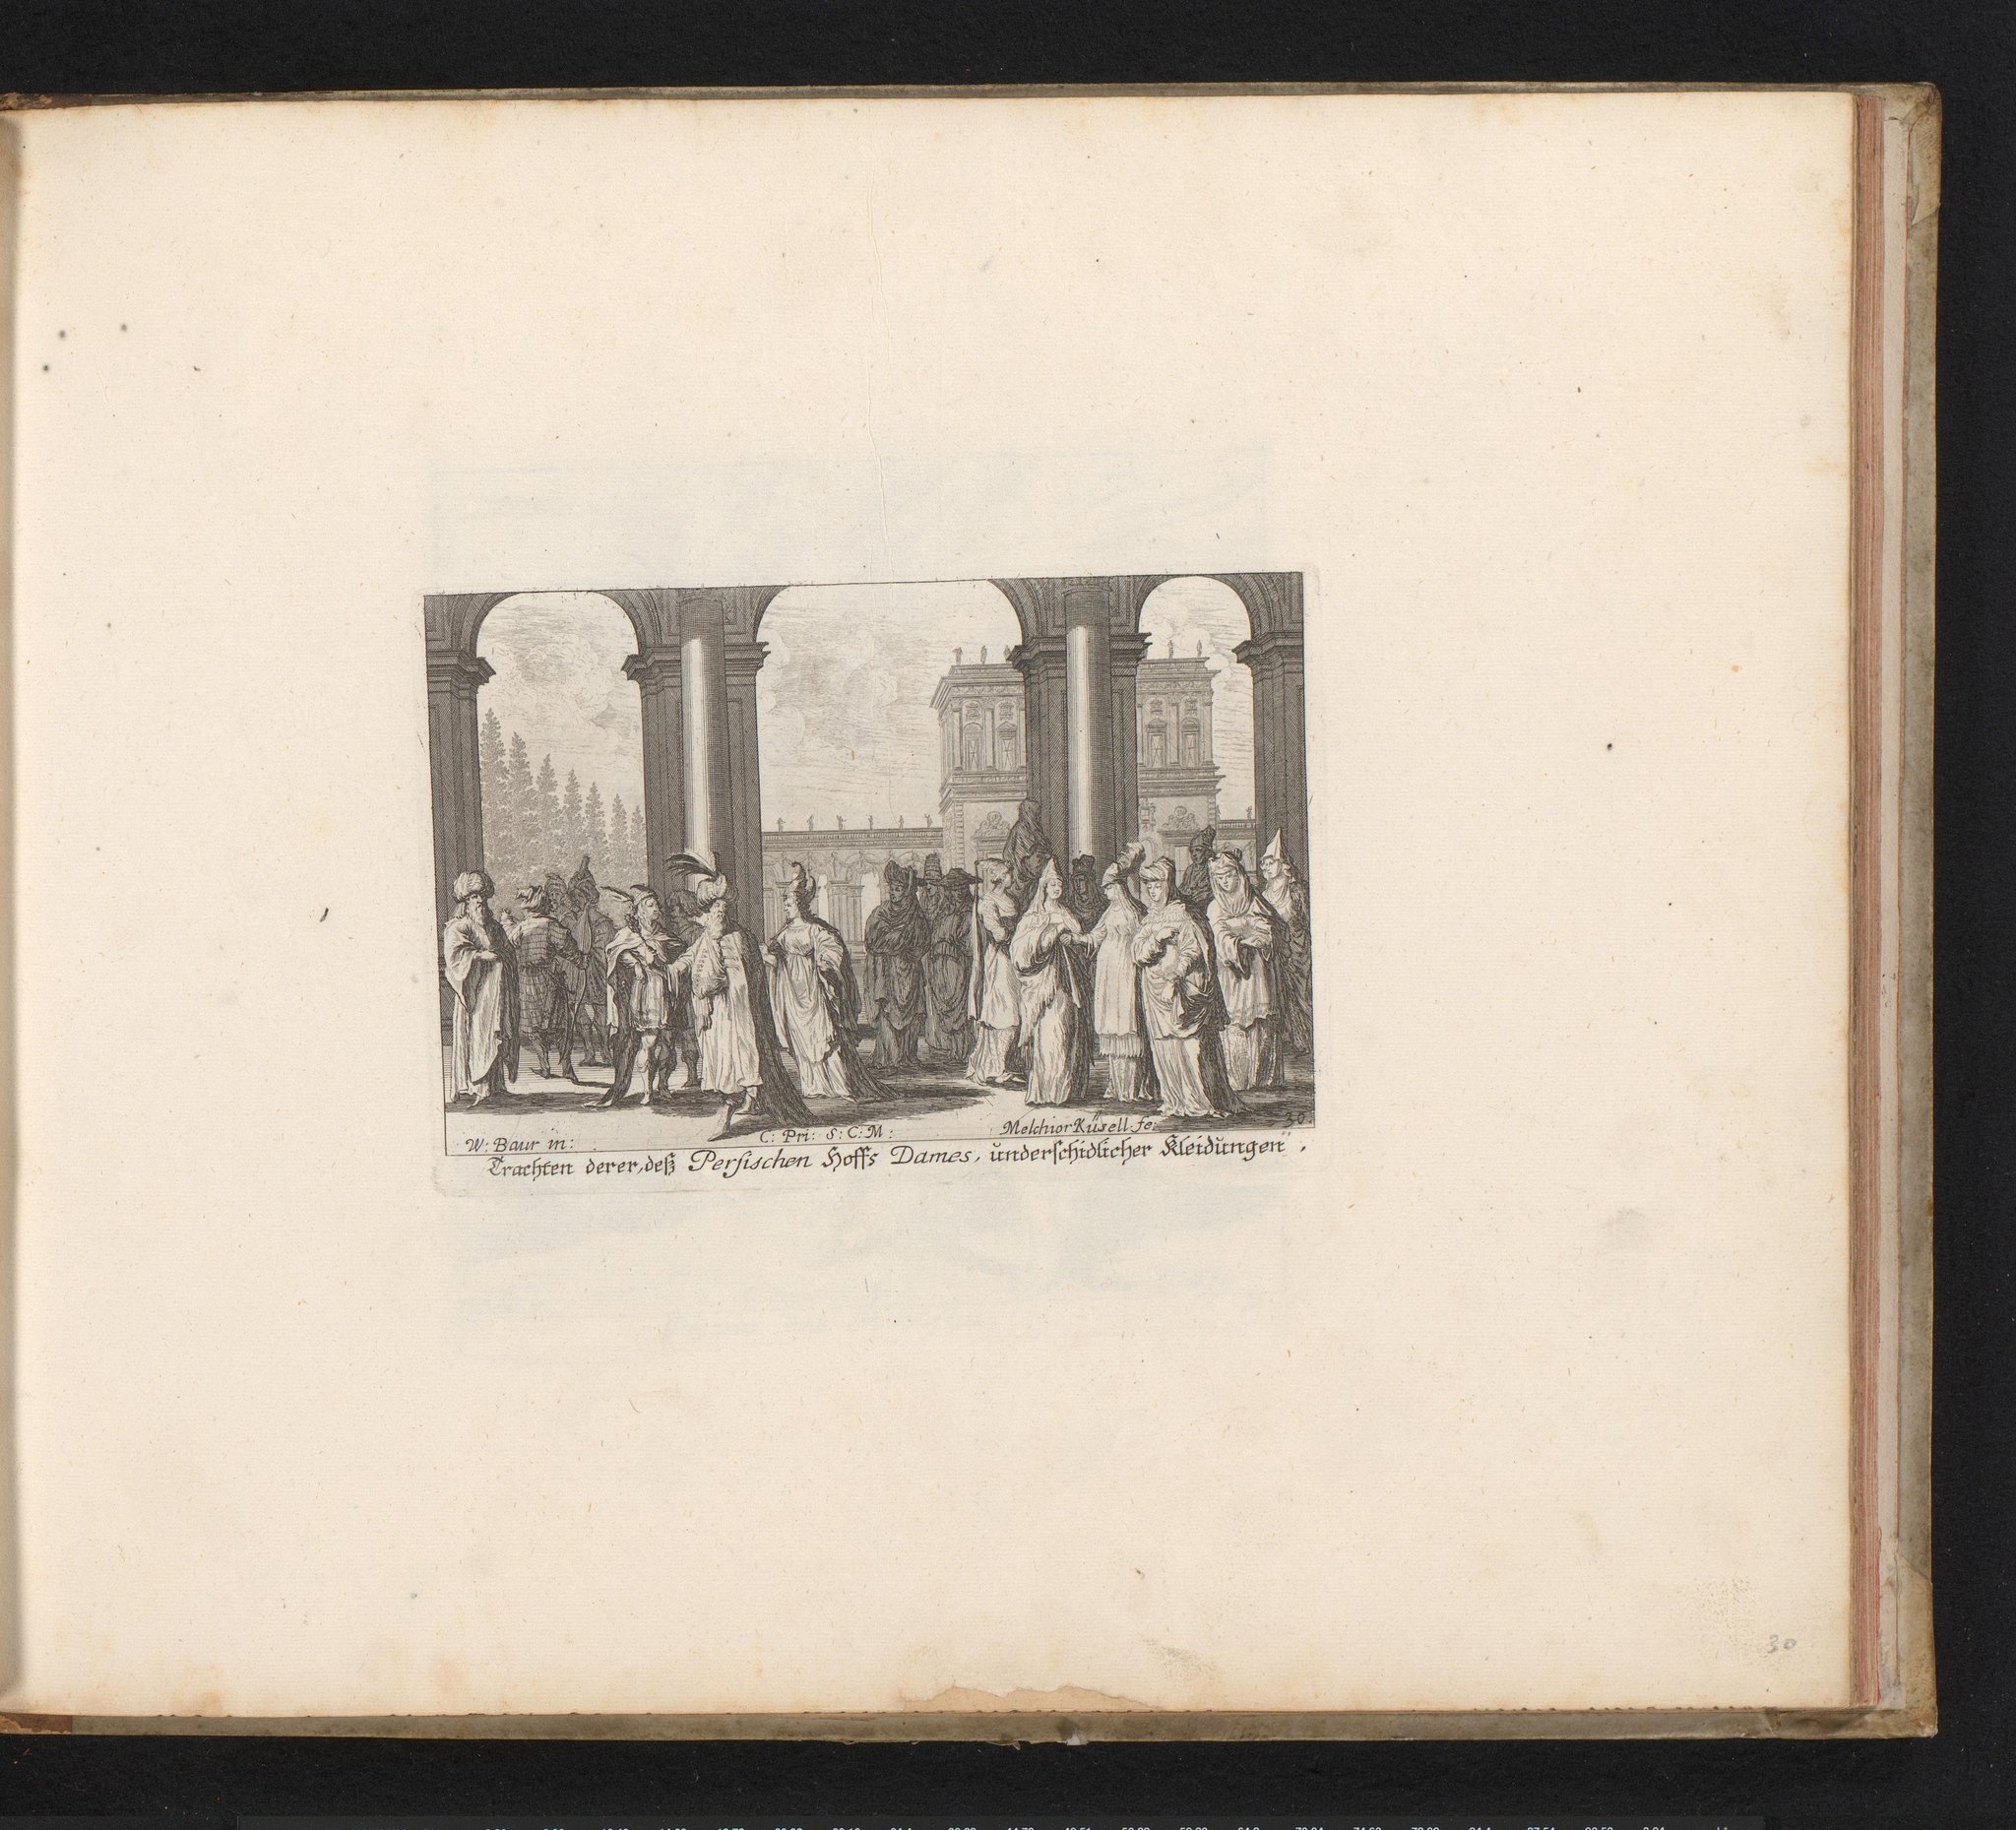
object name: album leaf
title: Figuren in een loggia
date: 1670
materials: paper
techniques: etching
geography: augsburg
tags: head-gear: turban, loggia, verandah, porch, veil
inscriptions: collector's mark: Lugt 2228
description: Tekst in het Duits in de ondermarge. Rechtsonder genummerd: 30. Prent maakt deel uit van een album.